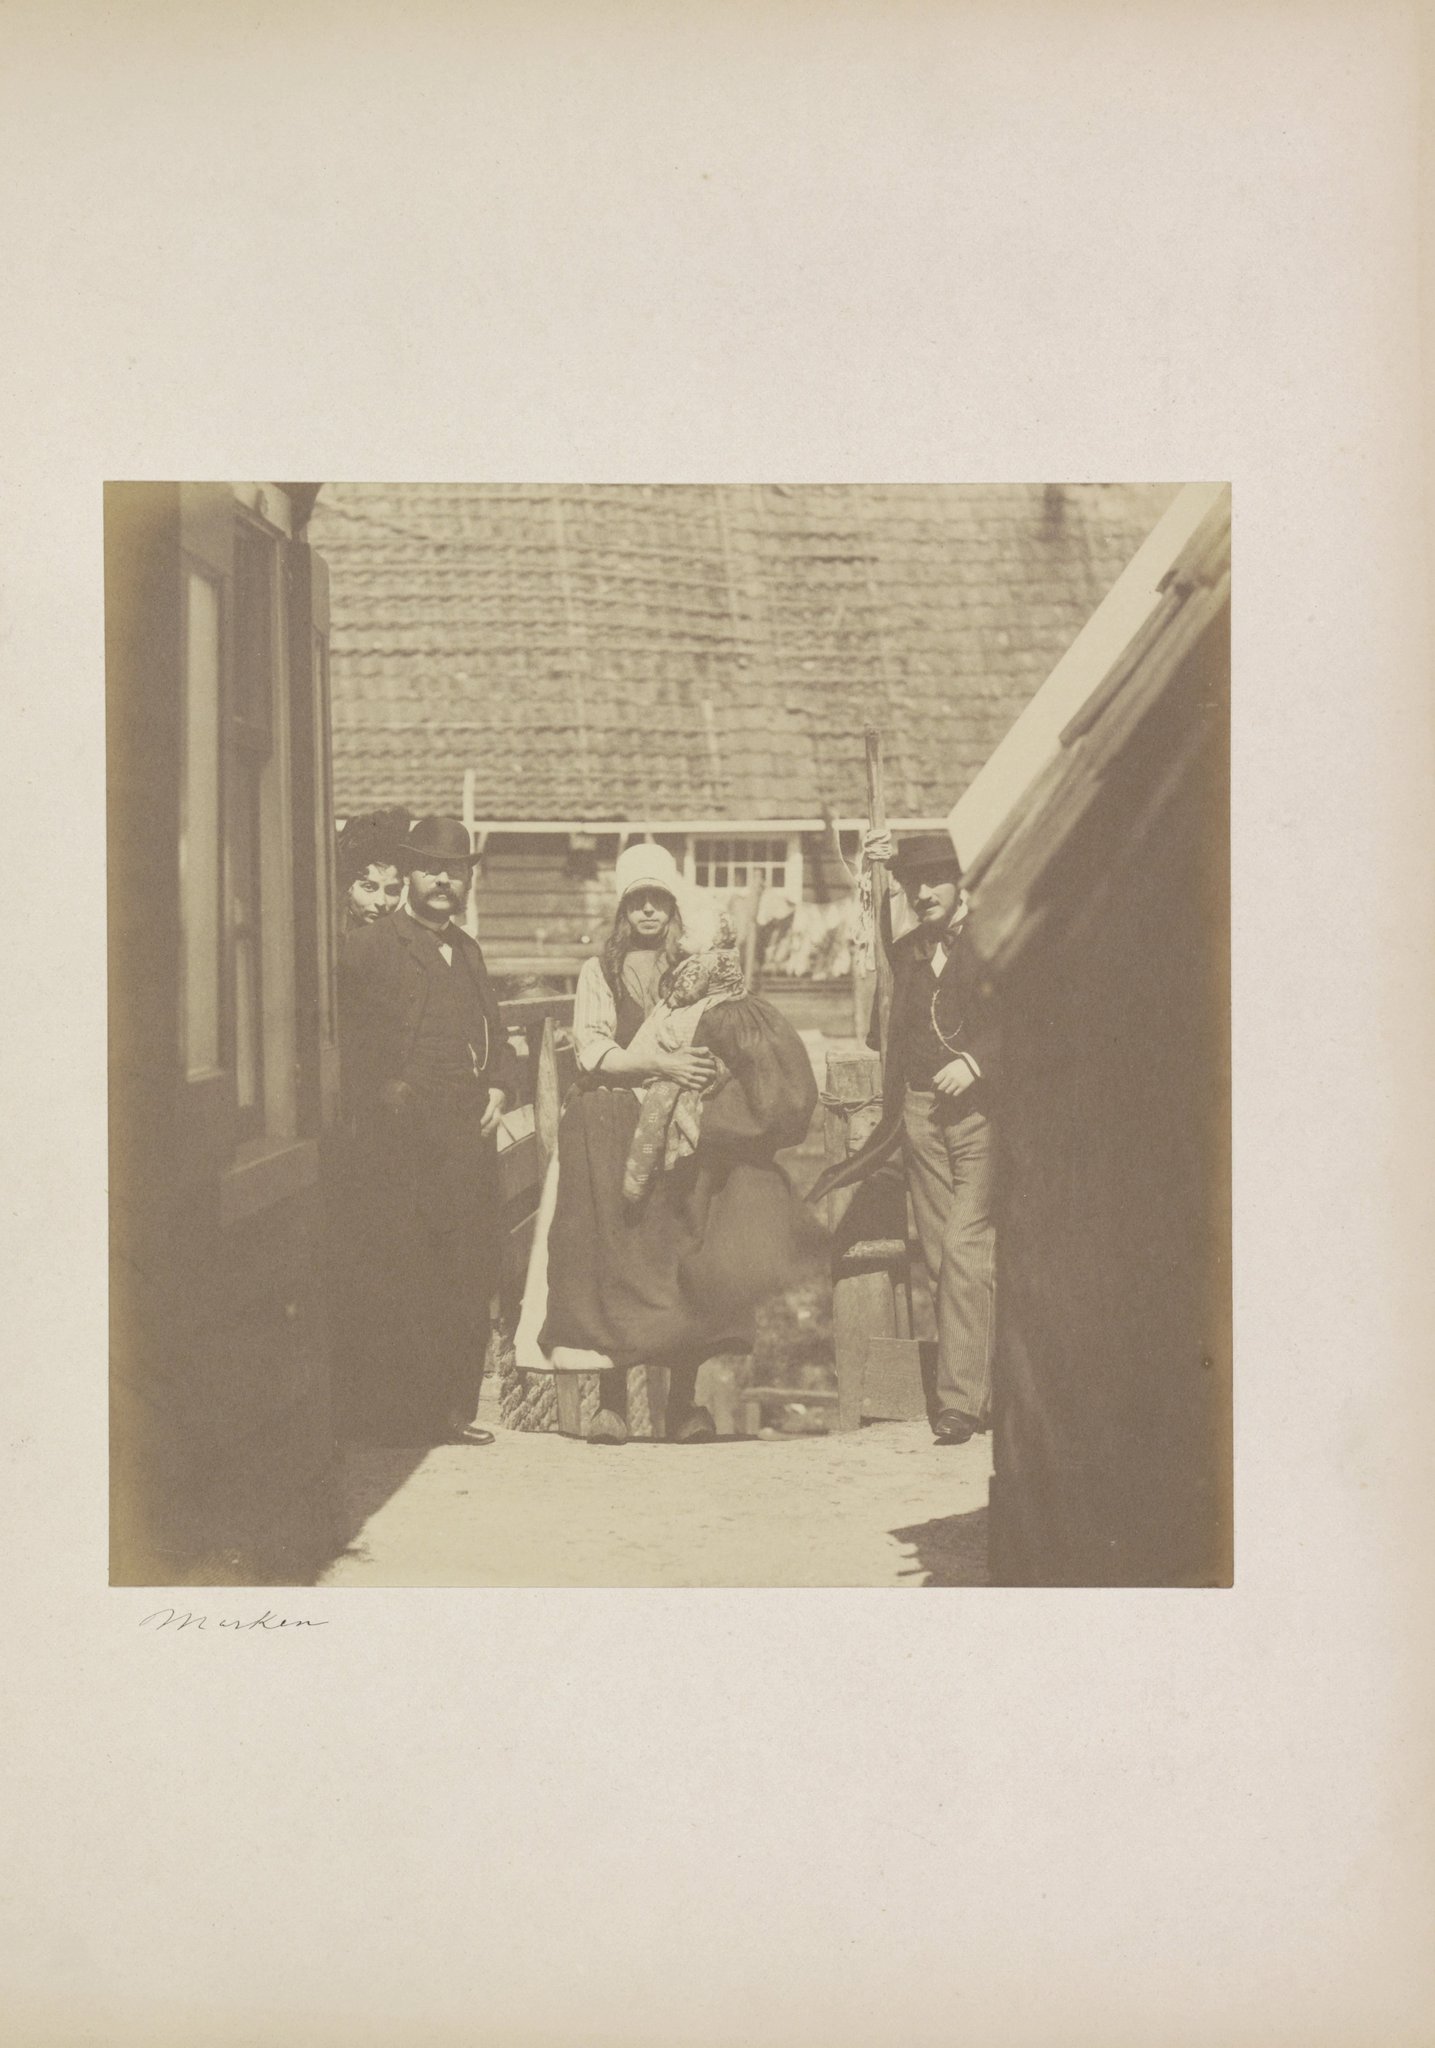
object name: photograph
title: Vrouw met een kind in klederdracht op Marken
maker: Anonymous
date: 1885-1900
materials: paper, photographic support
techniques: albumen print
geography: marken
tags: marken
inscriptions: annotation: ‘Hollande’, annotation: ‘Marken’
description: Een vrouw met een kind in klederdracht met twee mannen en een vrouw van het reisgezelschap, Marken.